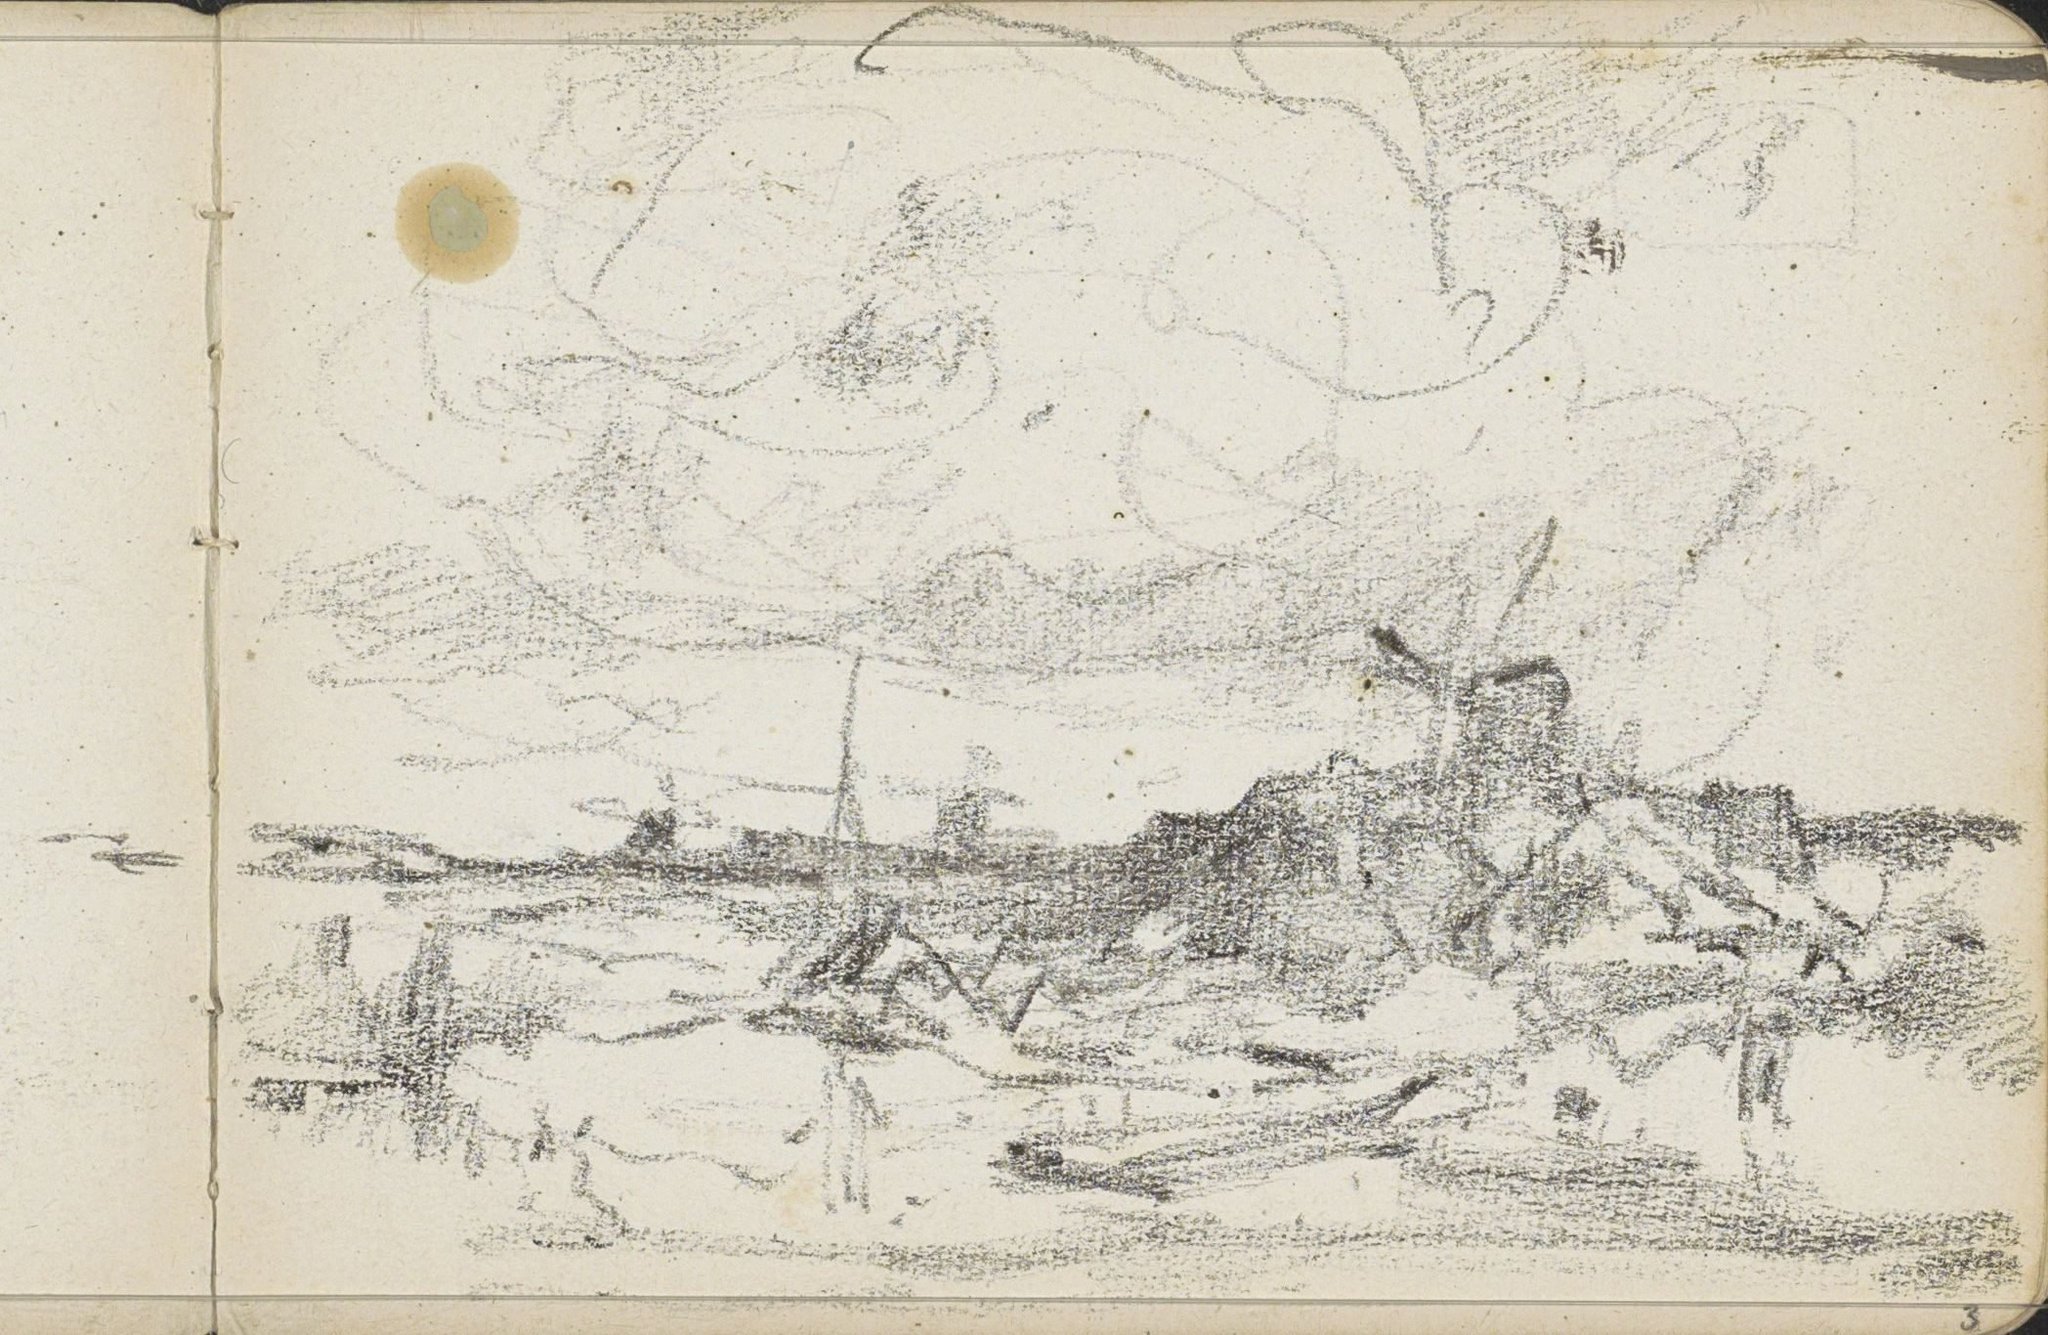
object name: sketchbook leaf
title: Rivierlandschap met molens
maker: willem cornelis rip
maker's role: draughtsman, painter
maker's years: 1856-1922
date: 1866-1922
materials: chalk, paper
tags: landscapes with waters, waterscapes, seascapes (in the temperate zone), windmill in landscape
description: Blad 3 recto uit een schetsboek met 42 bladen.